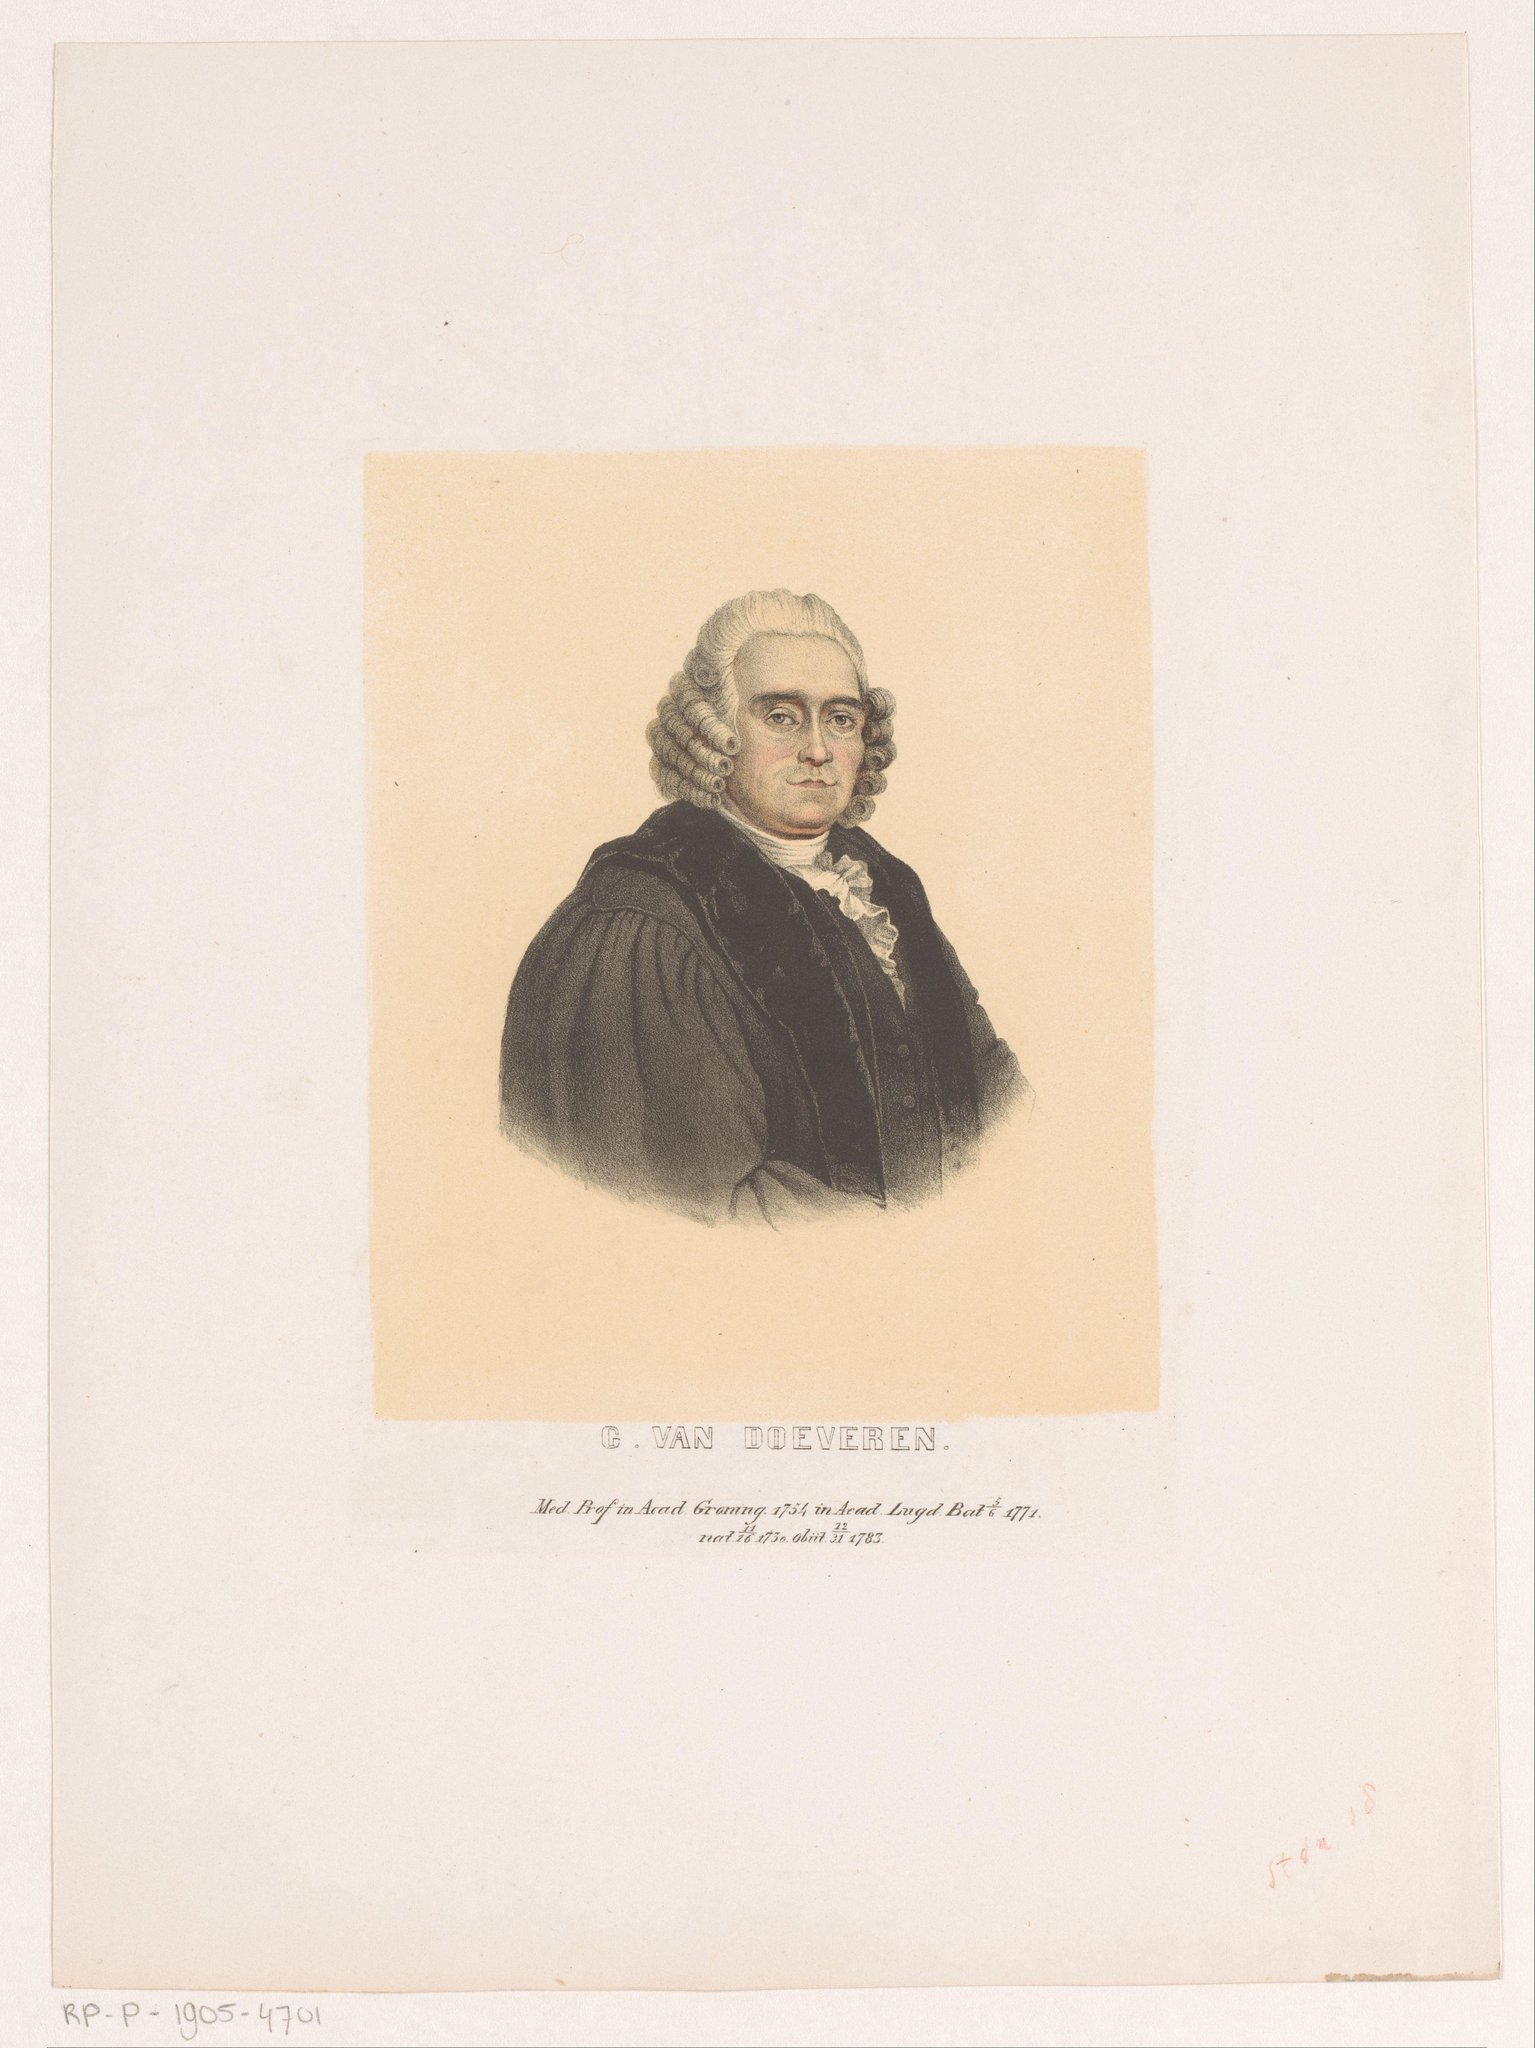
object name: print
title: Portret van Gualtherus van Doeveren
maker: leendert springer (i)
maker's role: draughtsman, painter, print maker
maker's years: 1789-1871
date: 1850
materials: paper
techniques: lithograph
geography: leiden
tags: leiden, historical persons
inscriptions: collector's mark: Lugt 2228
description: Prent uit: Springer, Leendert. Galerij van hoogleeraren aan de Hoogeschool te Leijden, naar de oorspronkelijke afbeeldsels op de Senaat-zaal aldaar berustende. Leiden: Springer, Leendert., s.a. [circa 1850].